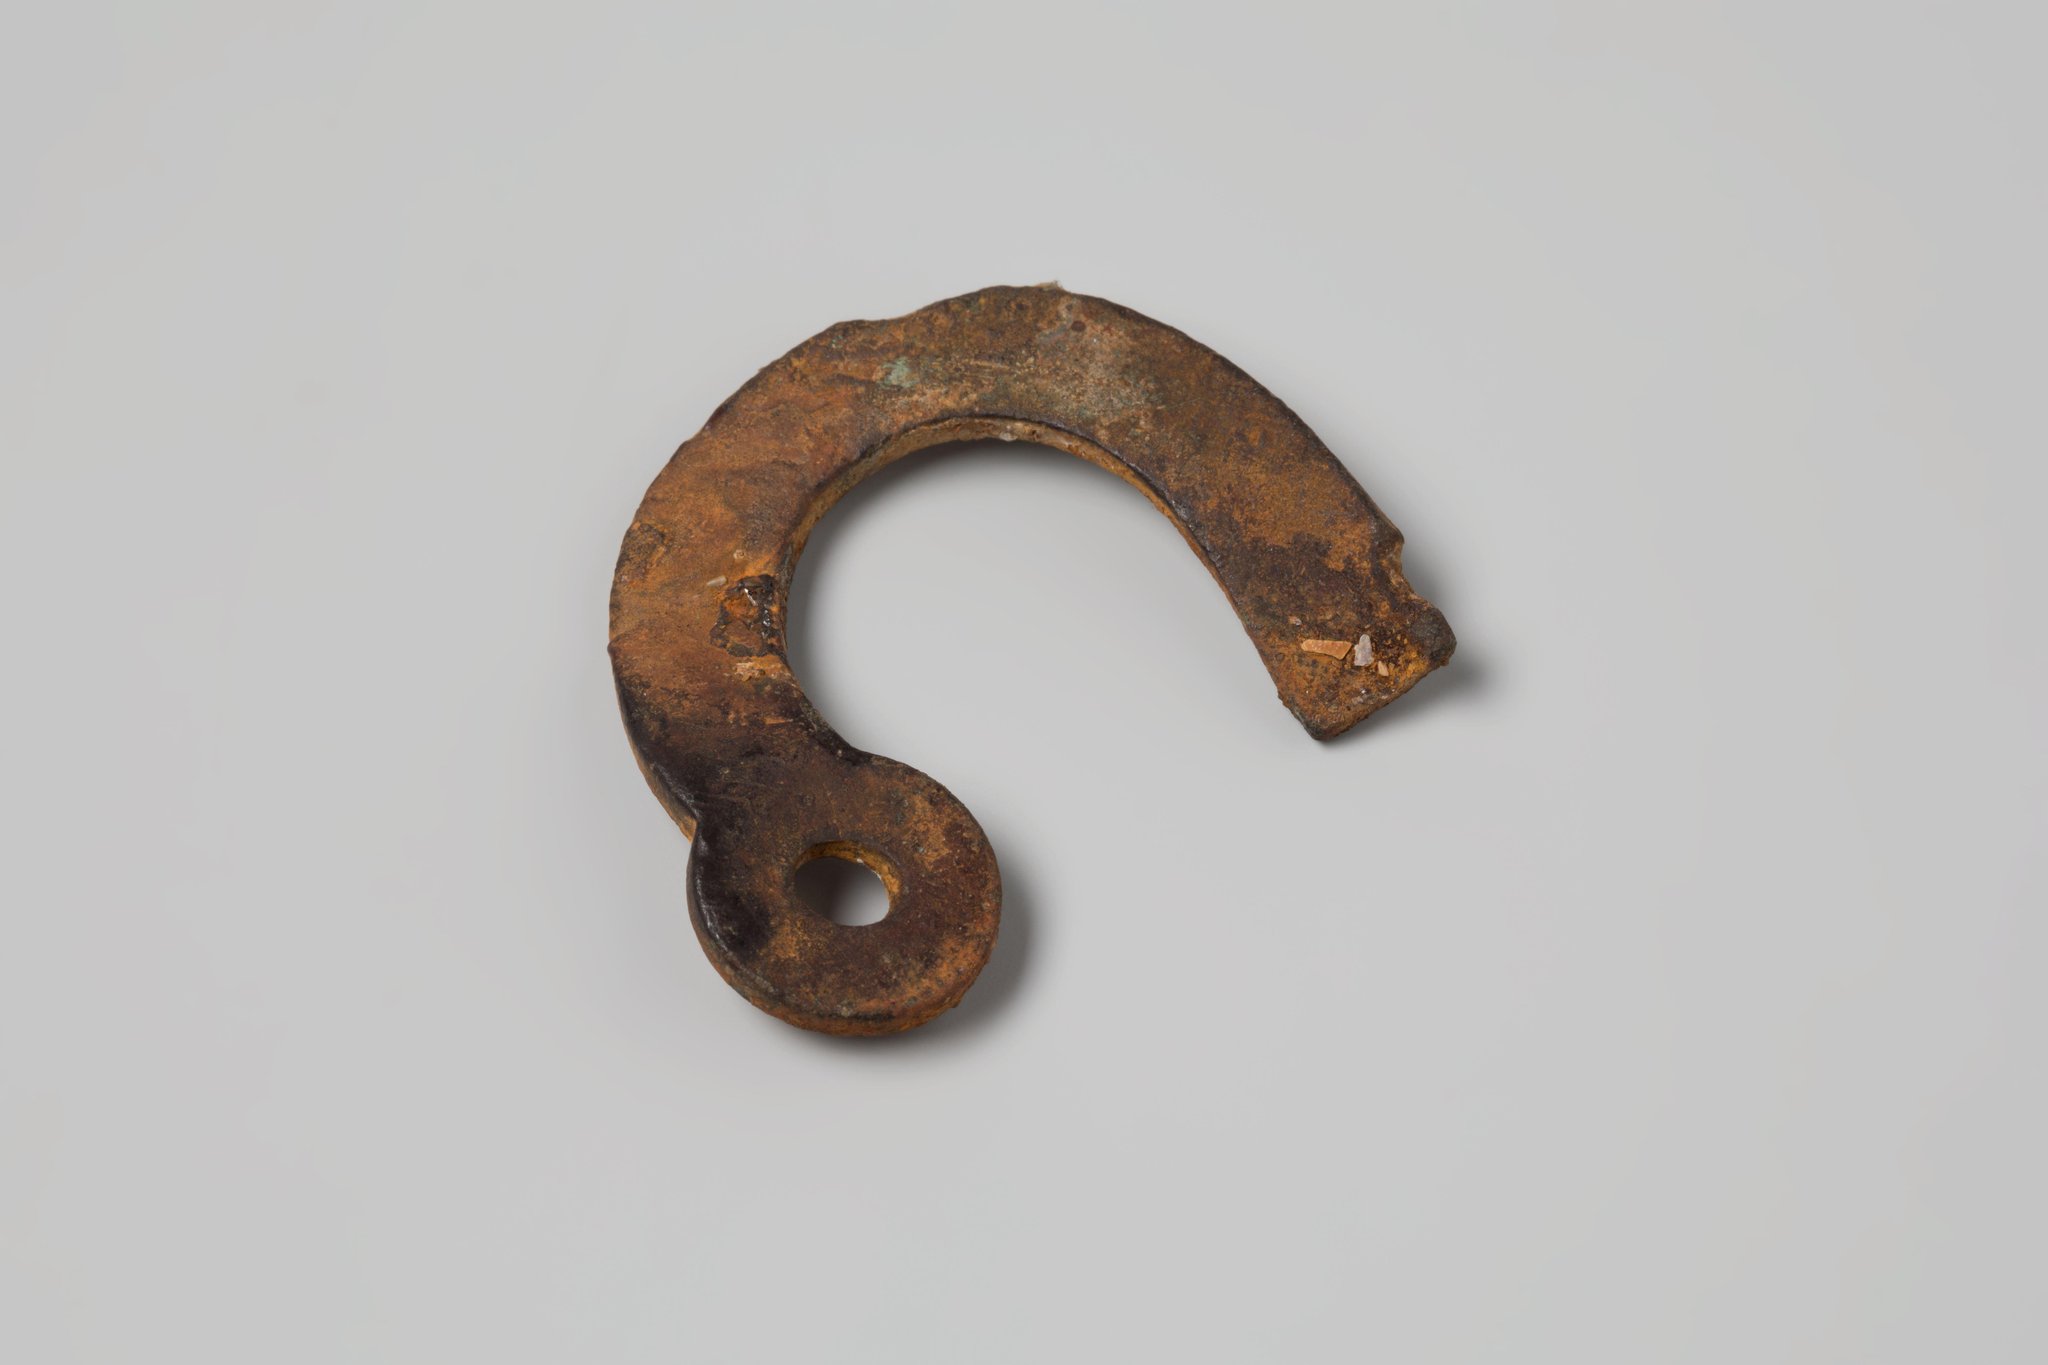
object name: divider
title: Fragment steekpasser uit het wrak van de Oost-Indiëvaarder Hollandia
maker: Anonymous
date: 1700-1743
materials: copper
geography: netherlands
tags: verenigde oostindische compagnie, hollandia (schip), annet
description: Divider; fragment, semicircular ring: flat in section, pierced circular end (acting as pivot), leg broken off.